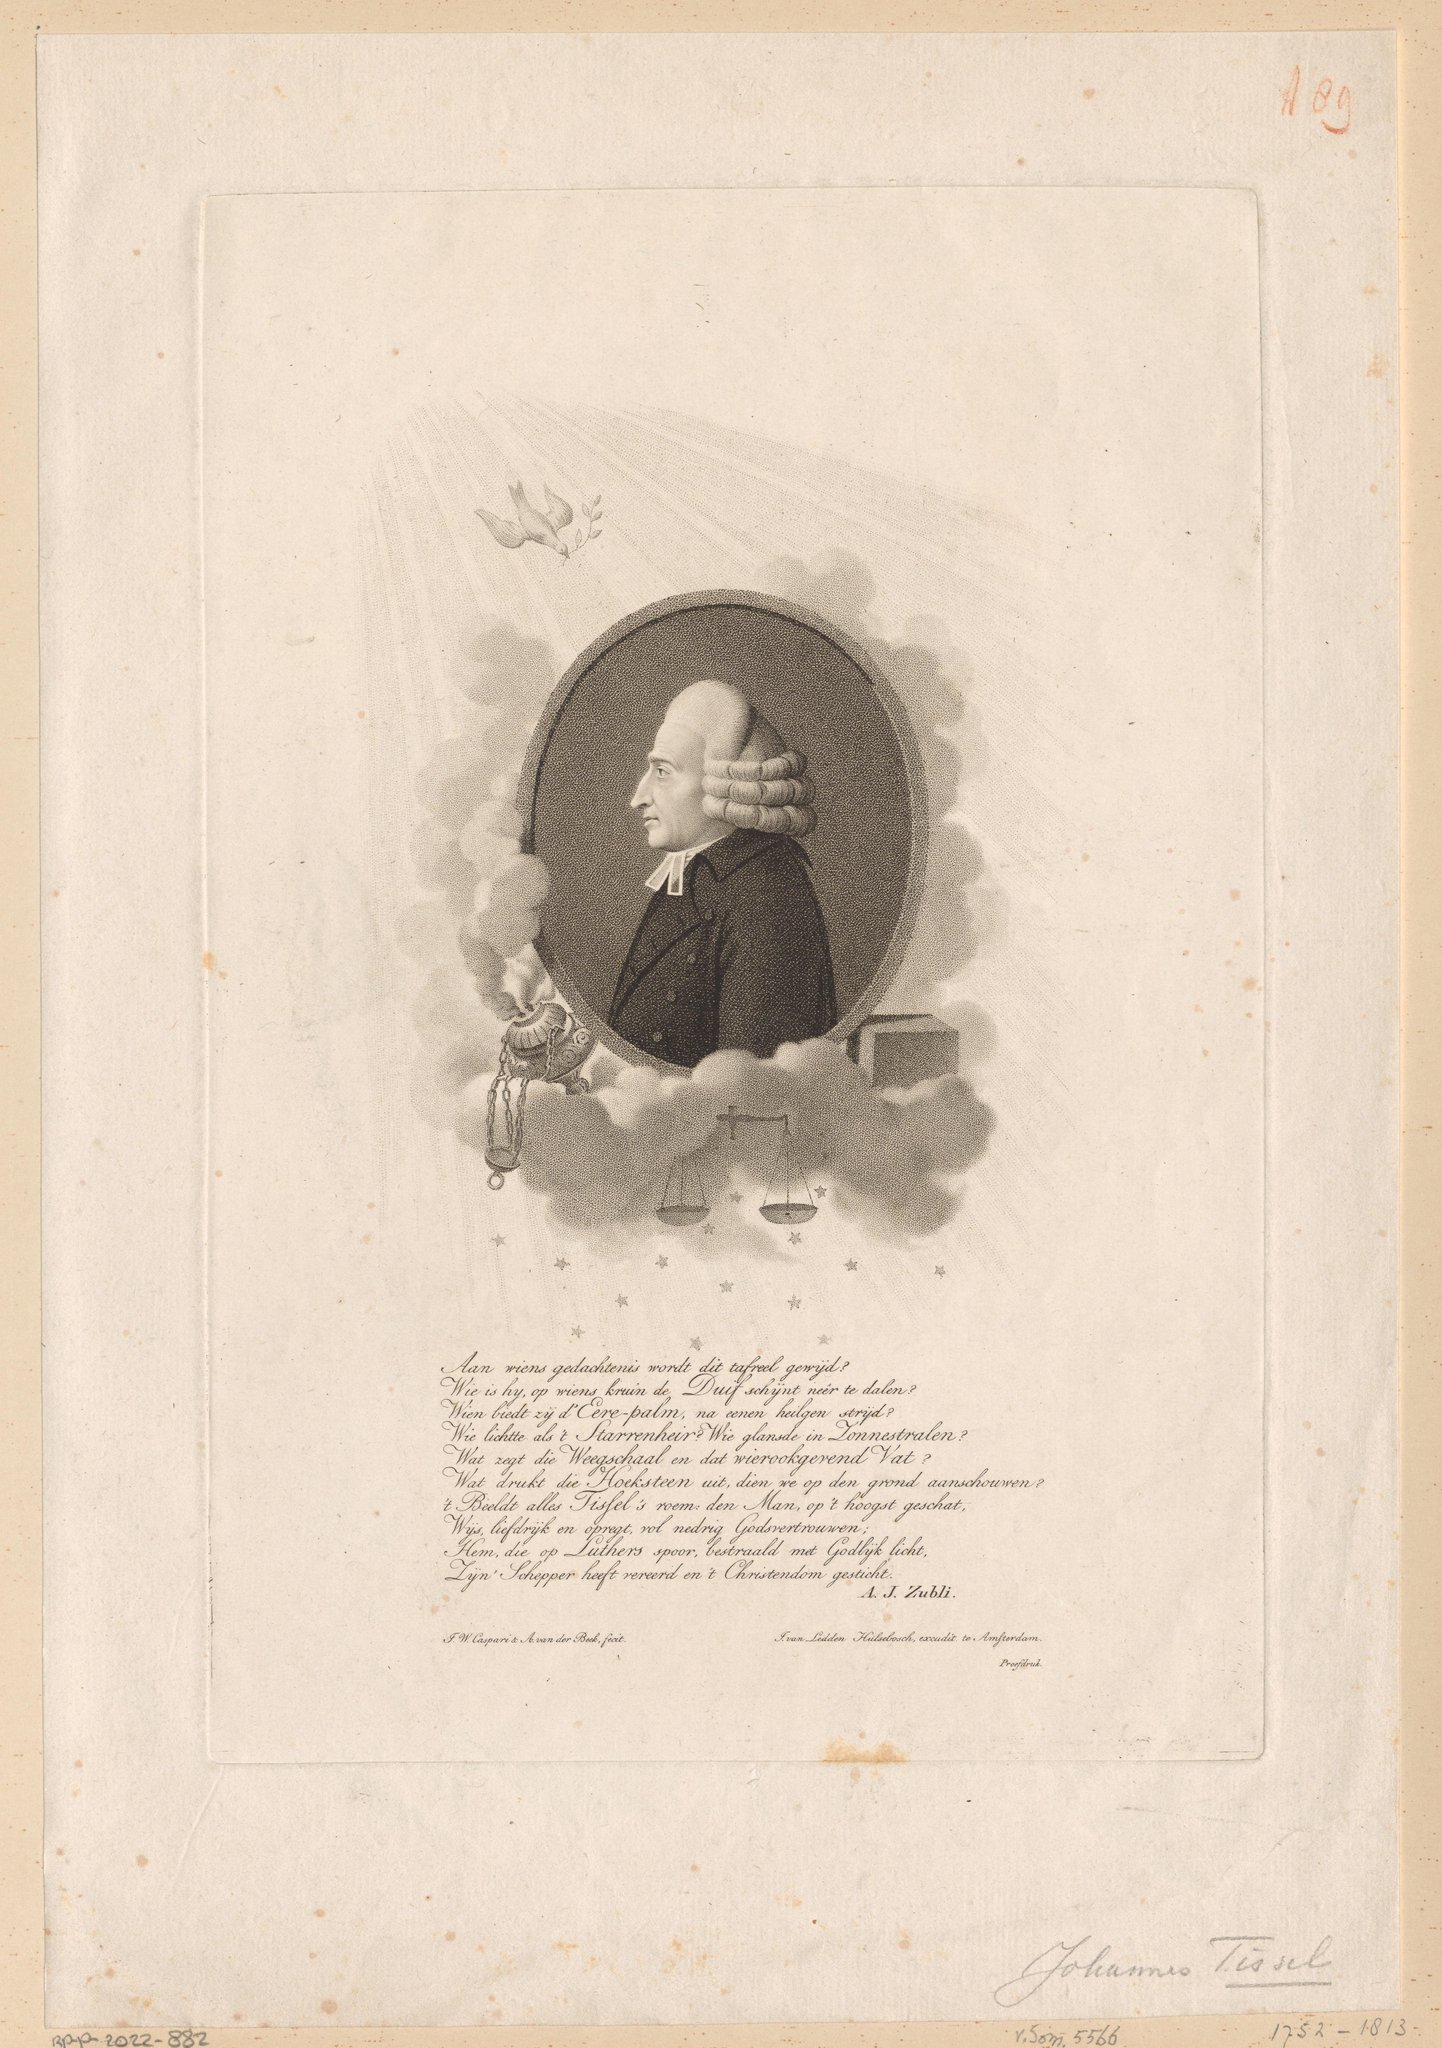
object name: print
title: Portret van Johannes Tissel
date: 1813-1815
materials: paper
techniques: etching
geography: amsterdam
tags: historical persons, functionaries and dignitaries ~ protestant churches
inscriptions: collector's mark: Lugt 2233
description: Met tienregelig lofdicht in het Nederlands onder het portret.